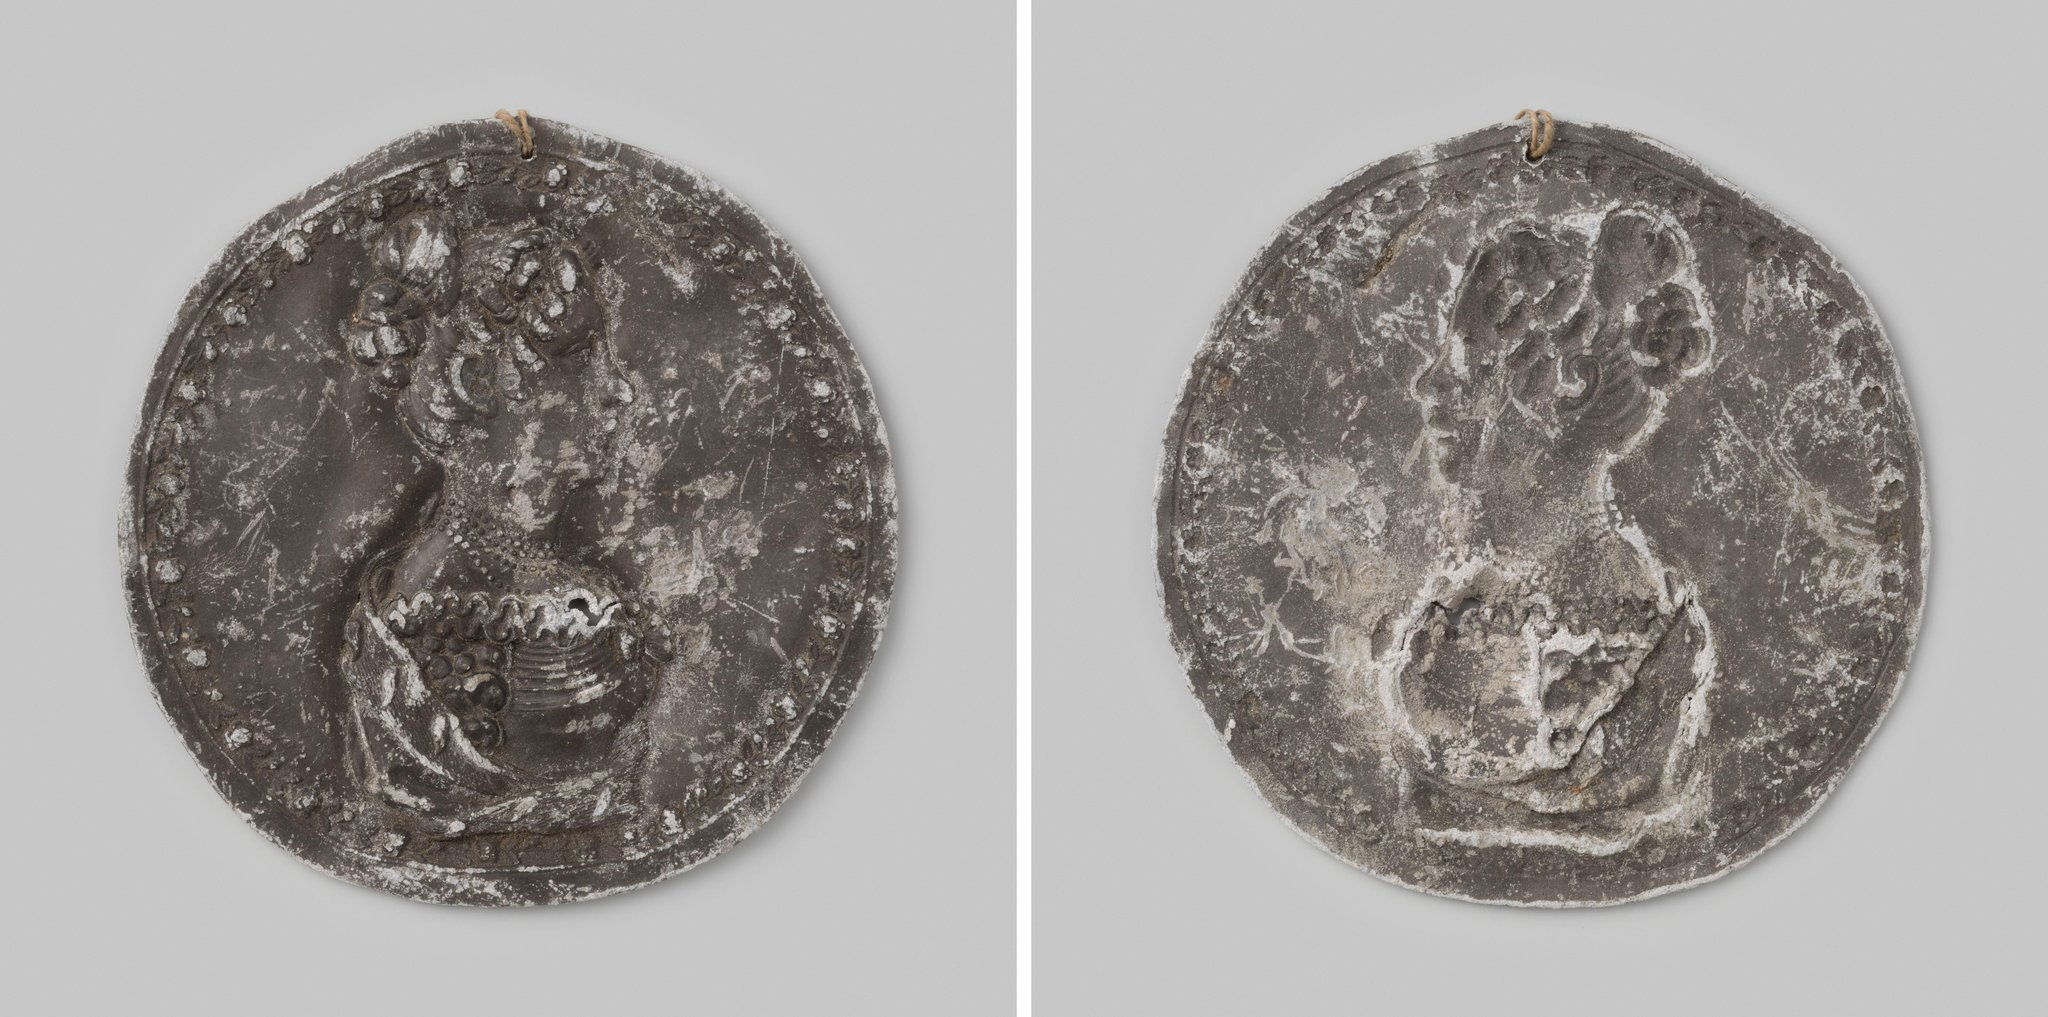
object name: history medal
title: Medaillon met vrouwenportret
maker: Anonymous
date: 1600-1800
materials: tin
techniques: pressing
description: Ronde plaat tin met spijkergat aan een touwtje, in relief het borstbeeld van een vrouw naar rechts met een bladerkrans langs de rand. Beschadigd.